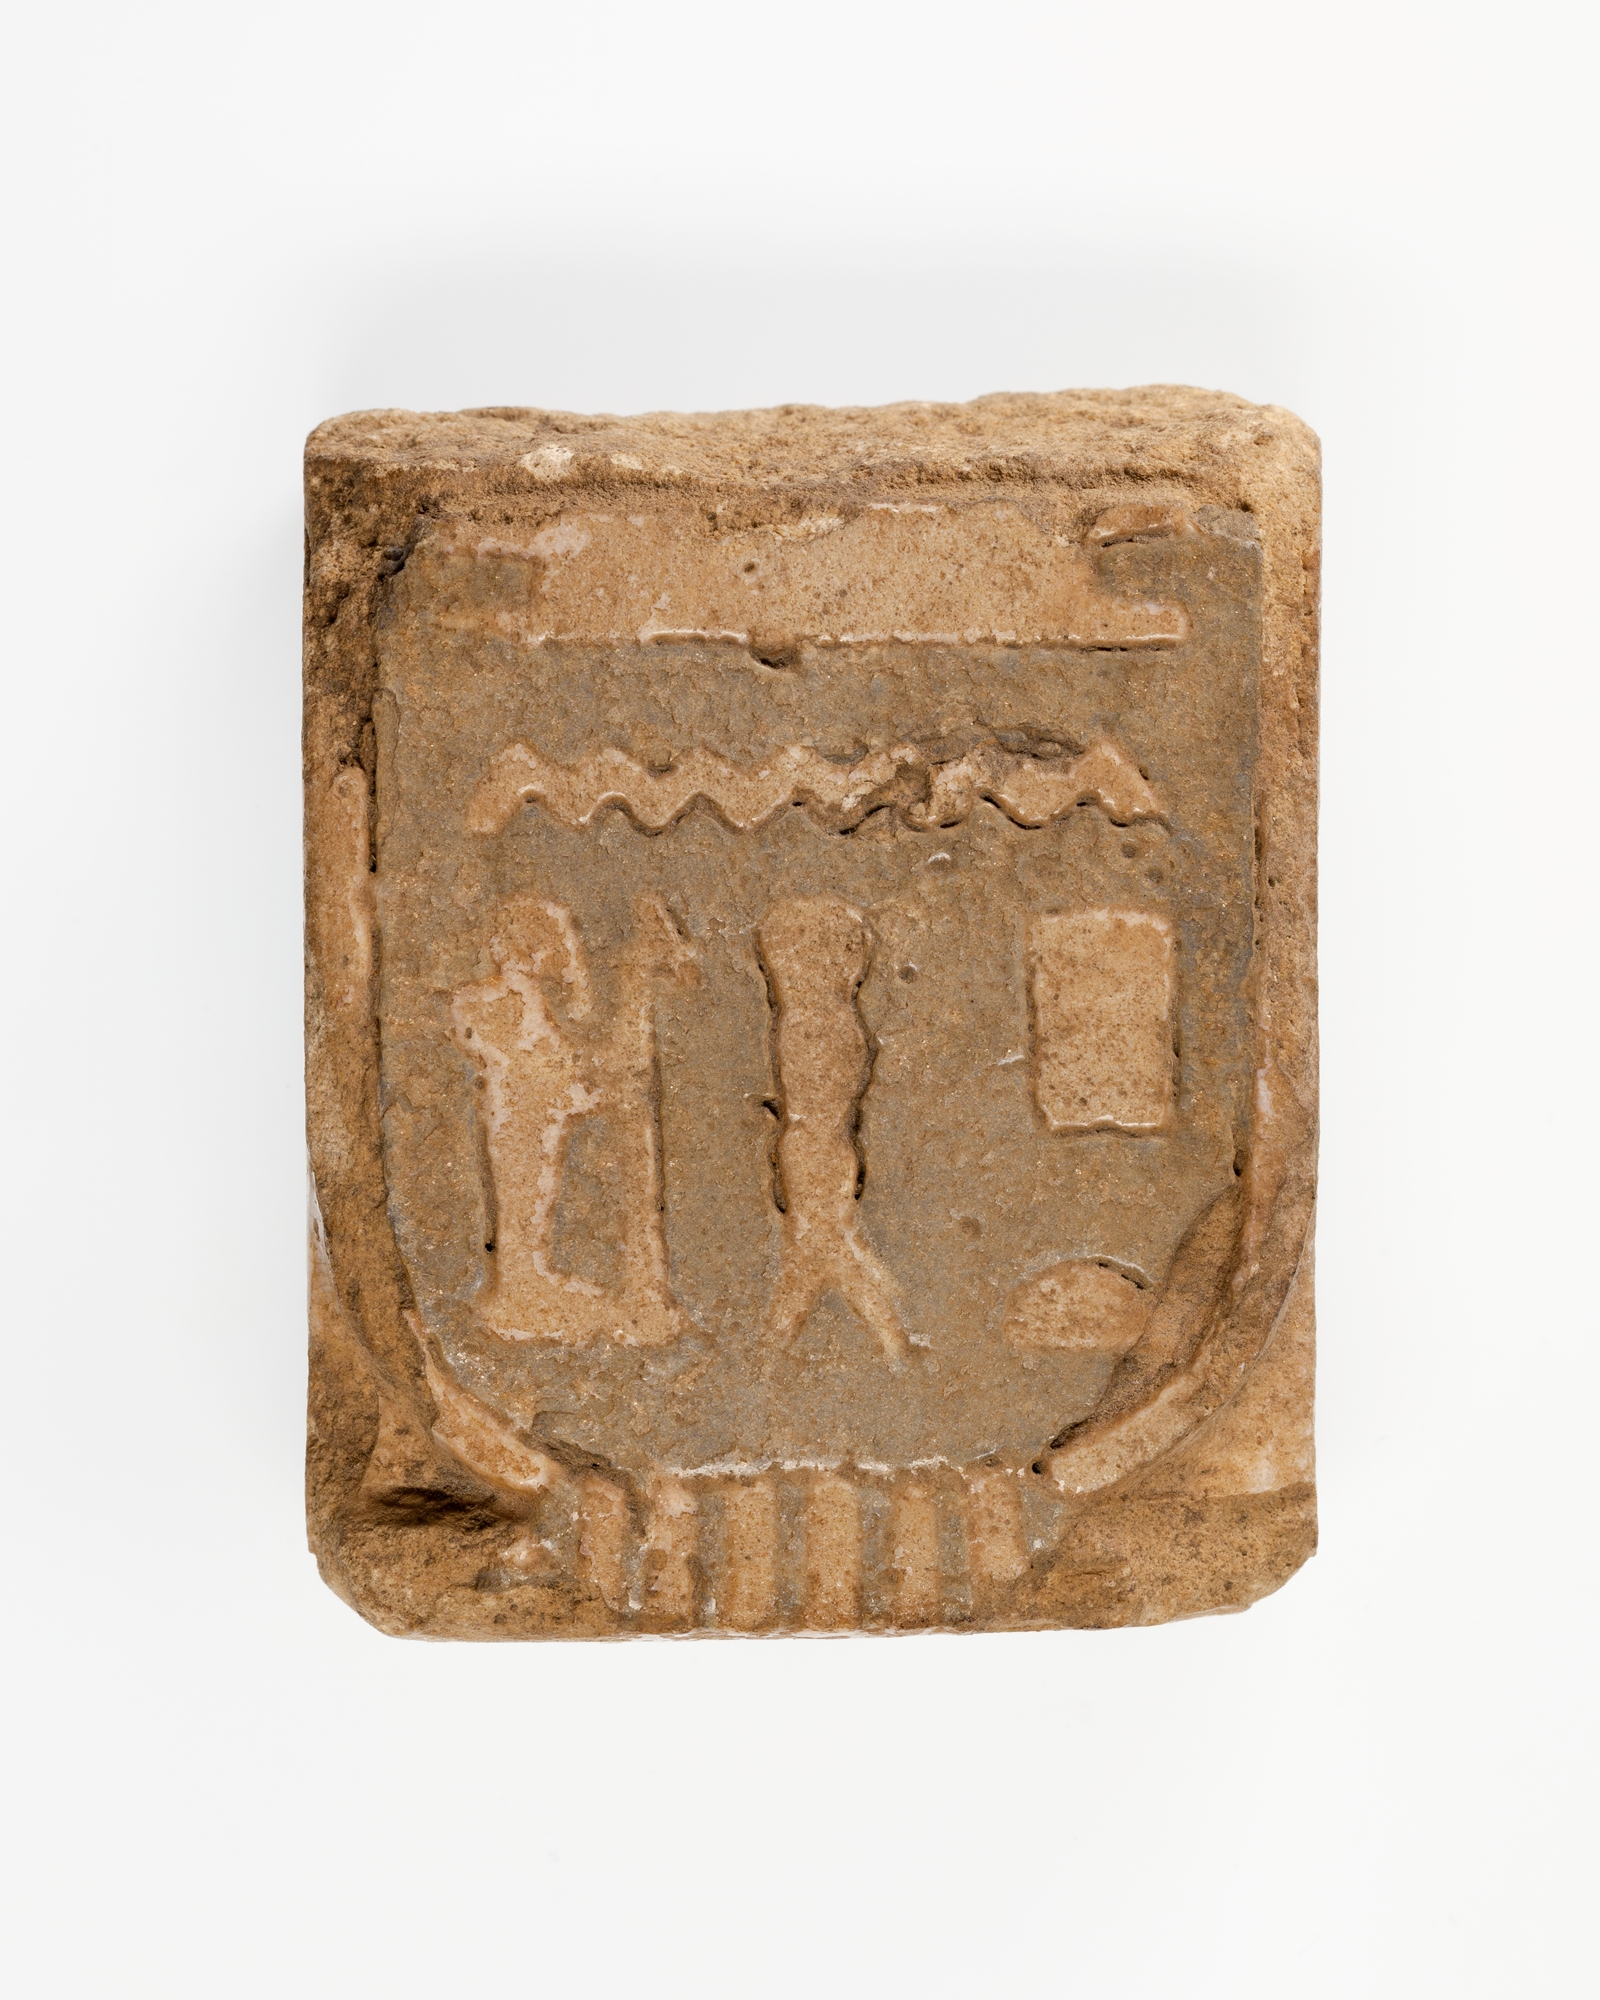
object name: tile fragment, seti ii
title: Fragment of tile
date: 1295-1070 BCE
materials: limestone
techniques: glazing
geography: egypt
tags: hieroglyphs